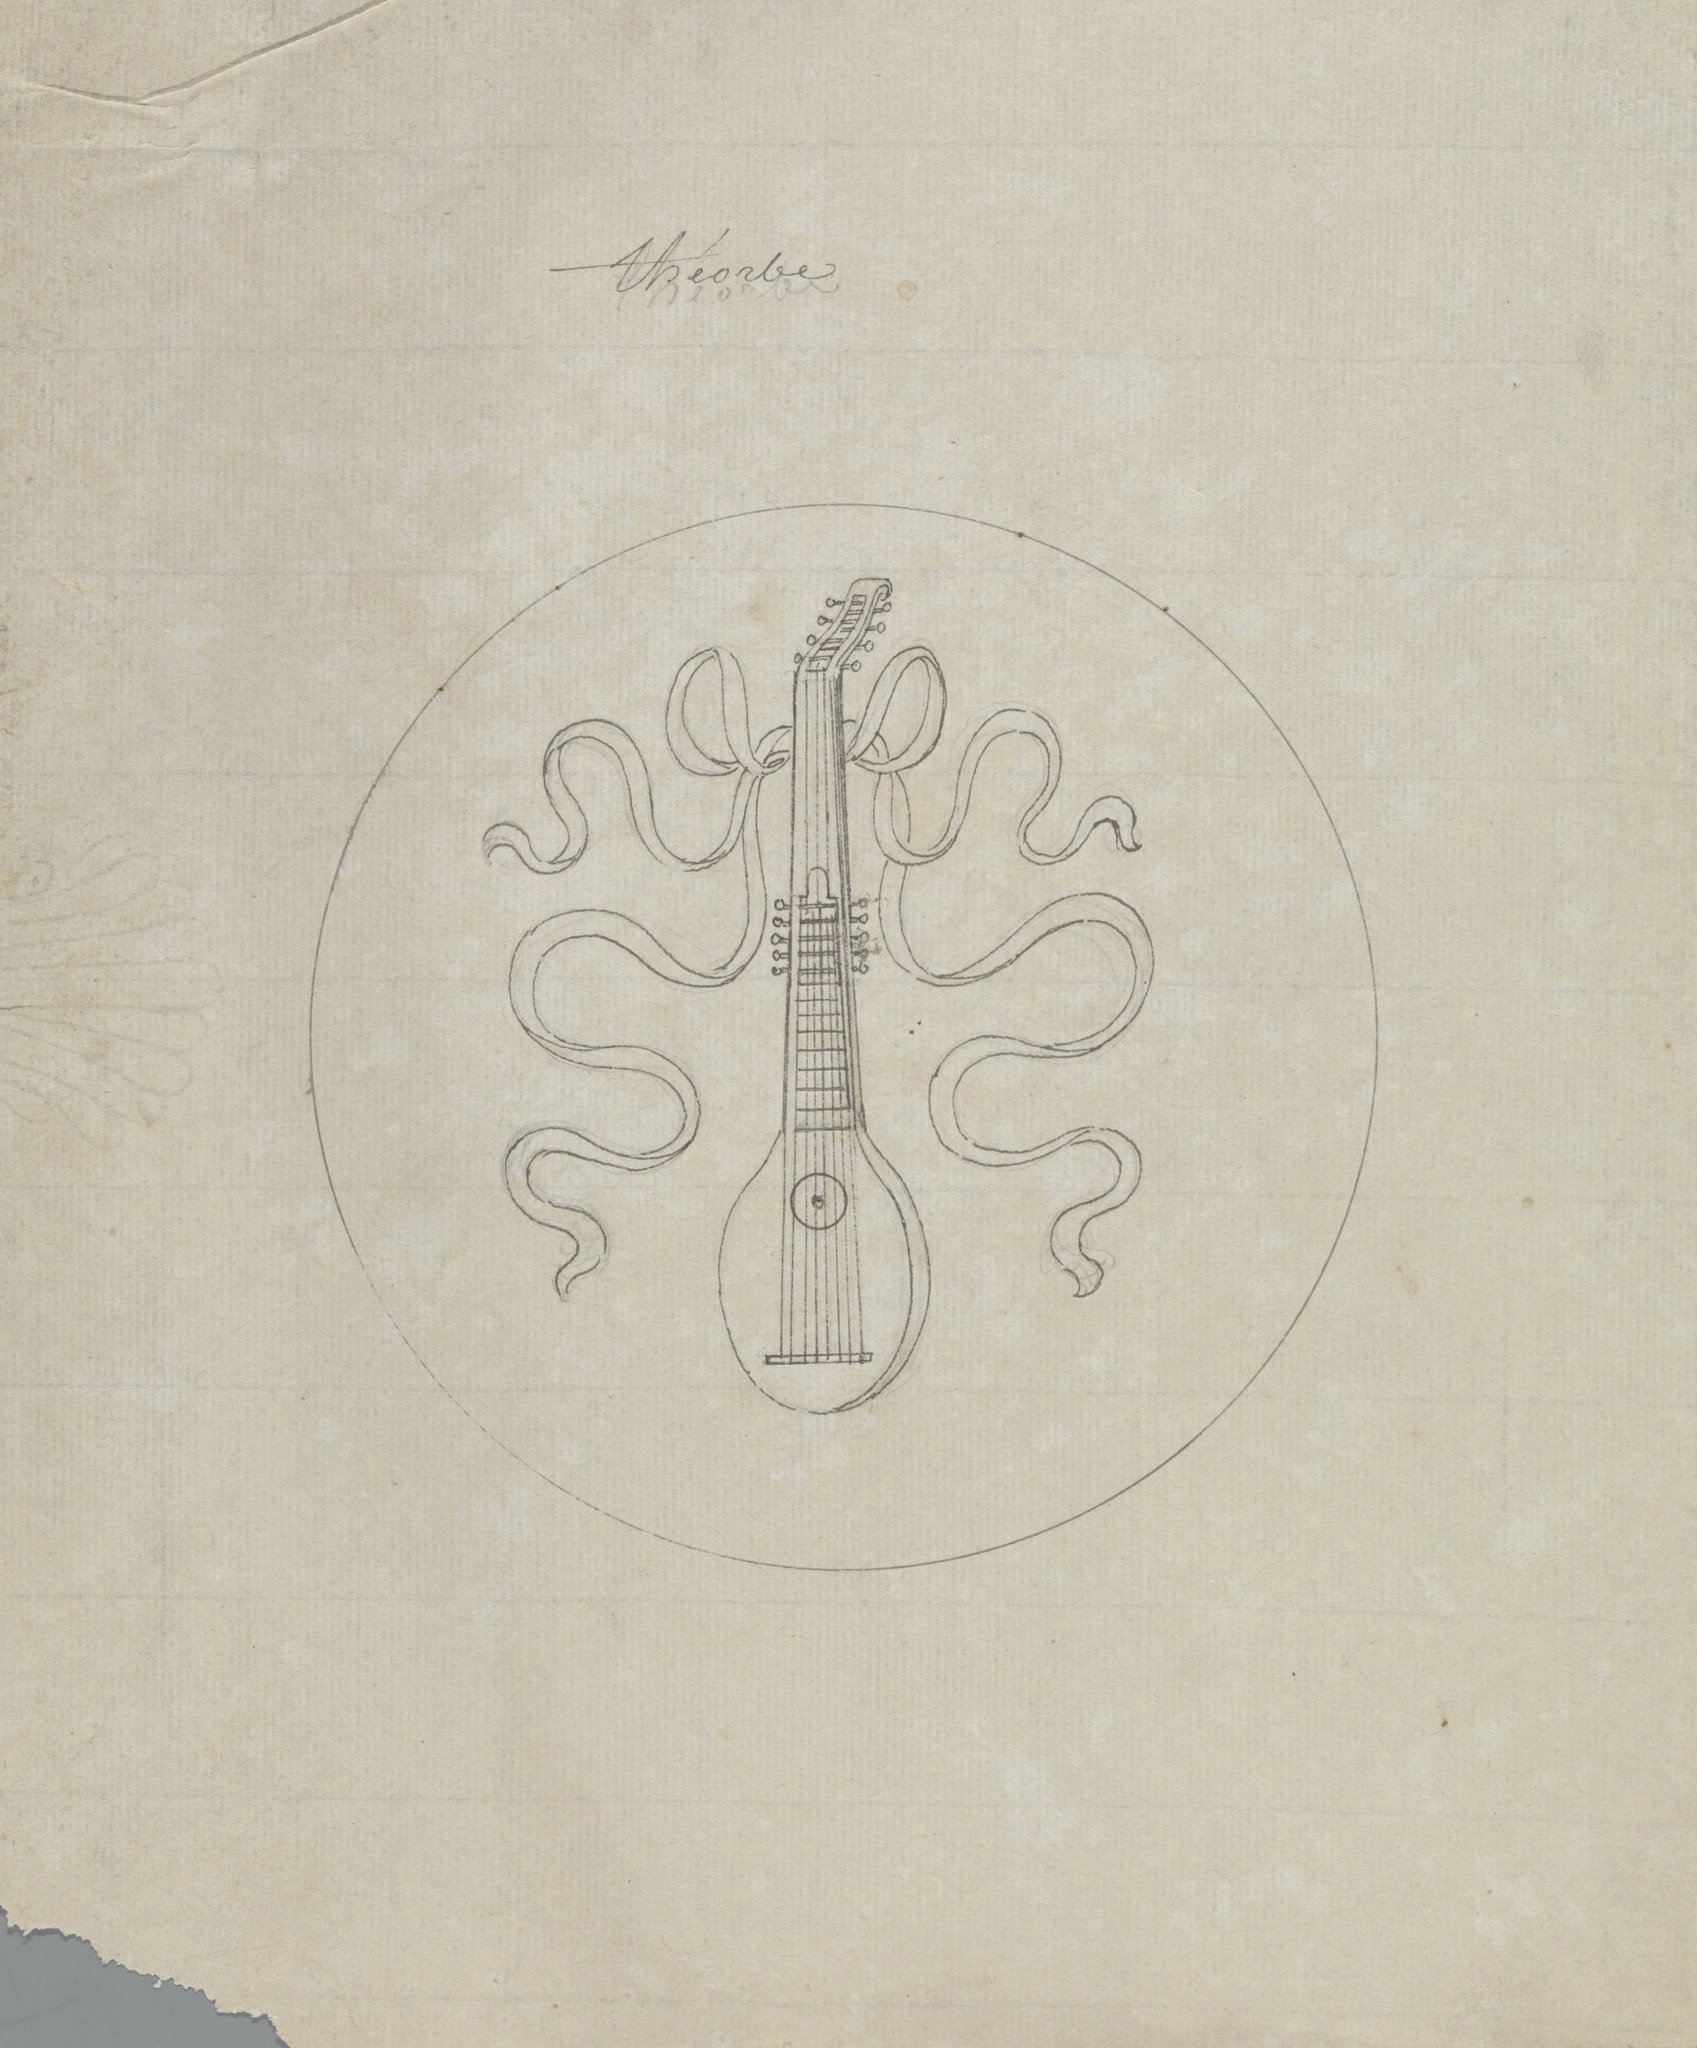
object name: design drawing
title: Ontwerp voor marqueterie van aan linten opgehangen muziekinstrument(en) in rond medaillon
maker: pierre félix van doren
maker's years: 1797-1856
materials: graphite, ink, paper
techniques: pen in black ink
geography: brussels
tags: trophy, i.e.: decorative arrangement of symbolic or typical objects ~ ornament, lute, and special forms of lute, e.g.: theorbo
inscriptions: watermark, inscription: ‘théorbe’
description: Een van 103 ontwerpen voor marqueterie van aan linten opgehangen muziekinstrumenten in ronde medaillons, bestemd voor de set stoelen gemaakt door Van Doren voor de grote zaal van het Paleis van de Prins van Oranje in Brussel in 1828.